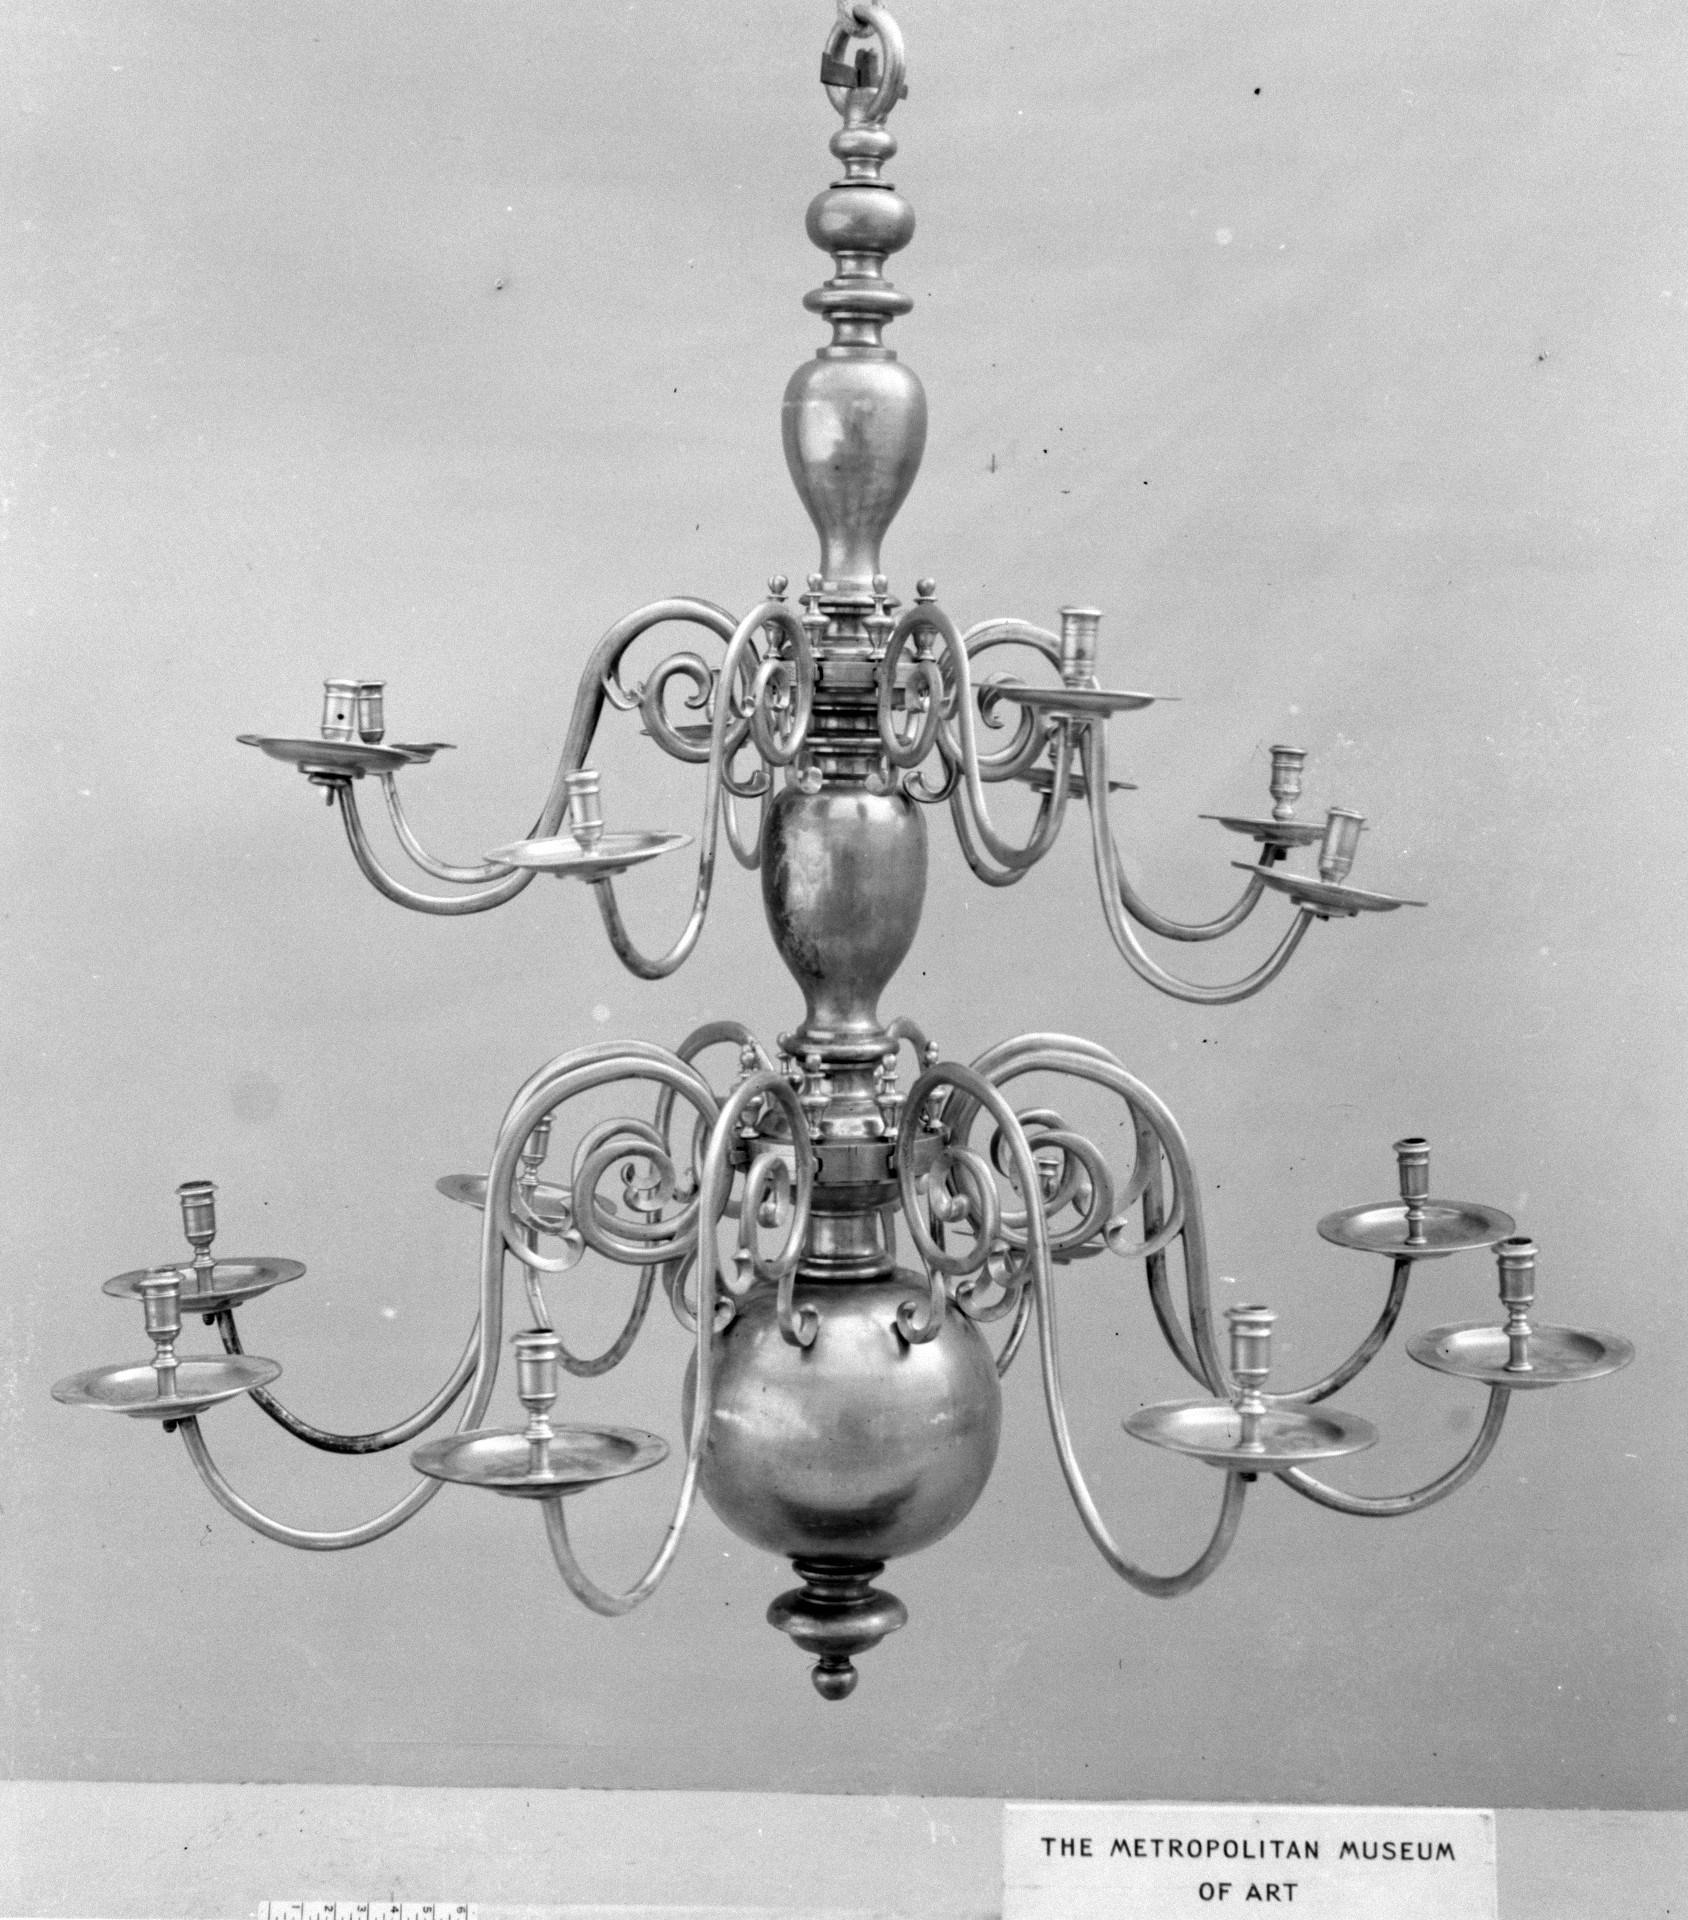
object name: chandelier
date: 1601-1700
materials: brass